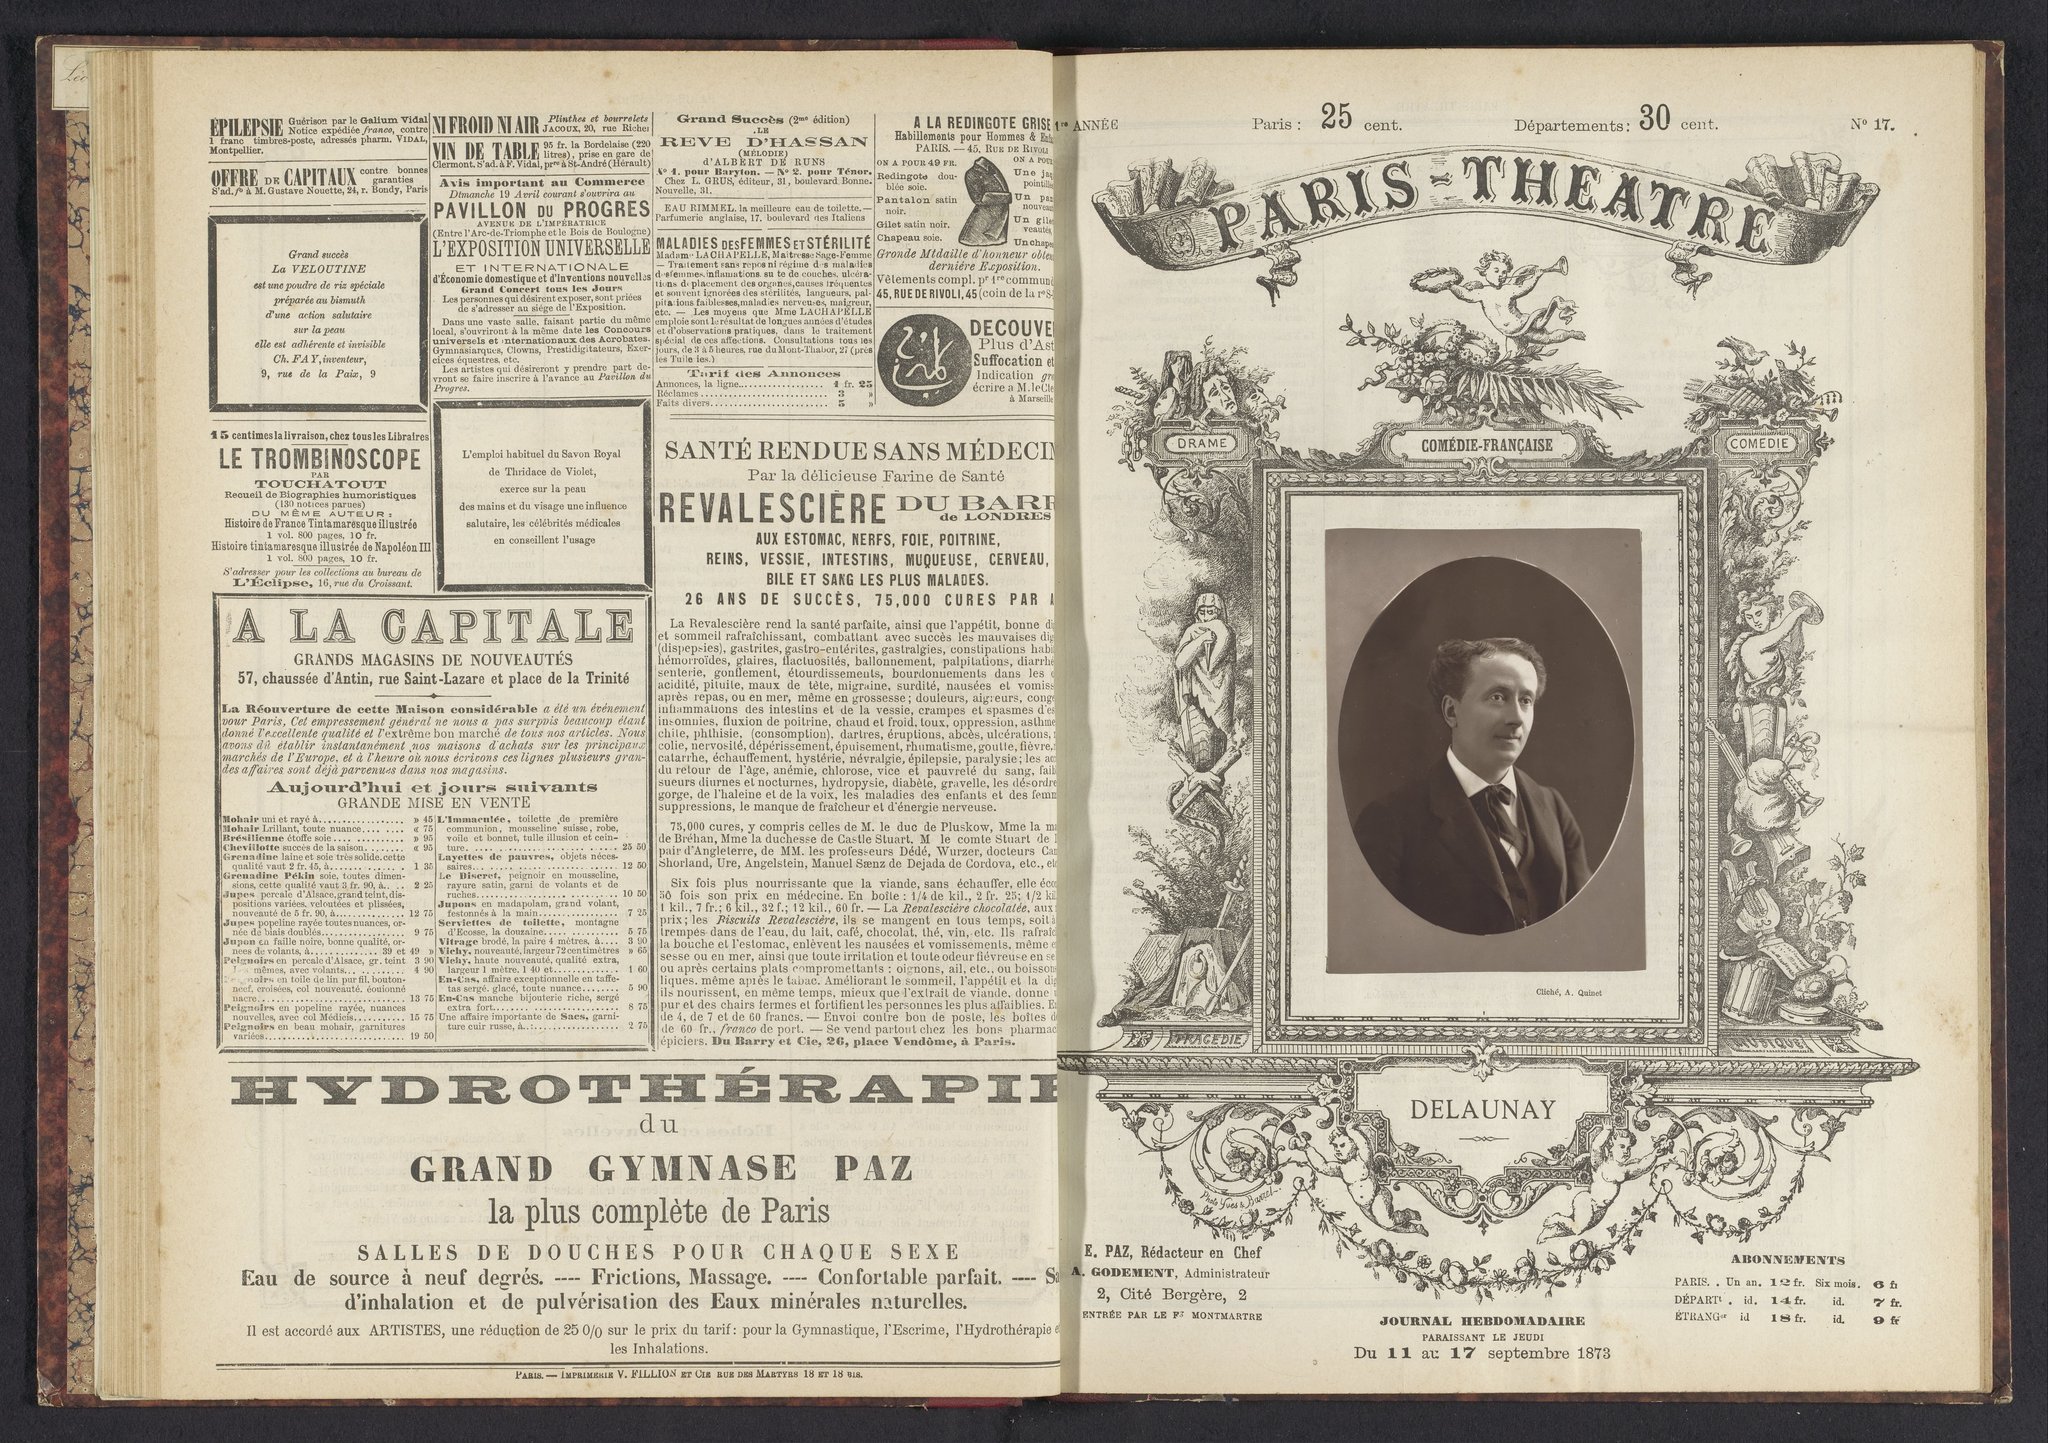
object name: page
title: Delaunay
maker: alexandre quinet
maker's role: fotograaf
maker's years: 1837-1900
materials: paper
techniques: woodburytype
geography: france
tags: louis-arsène delaunay, portrait of actor, actress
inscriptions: number: ‘No 17.’, inscription: ‘Journal hebdomadaire paraissant le jeudi du 11 au 17 Septembre 1873’